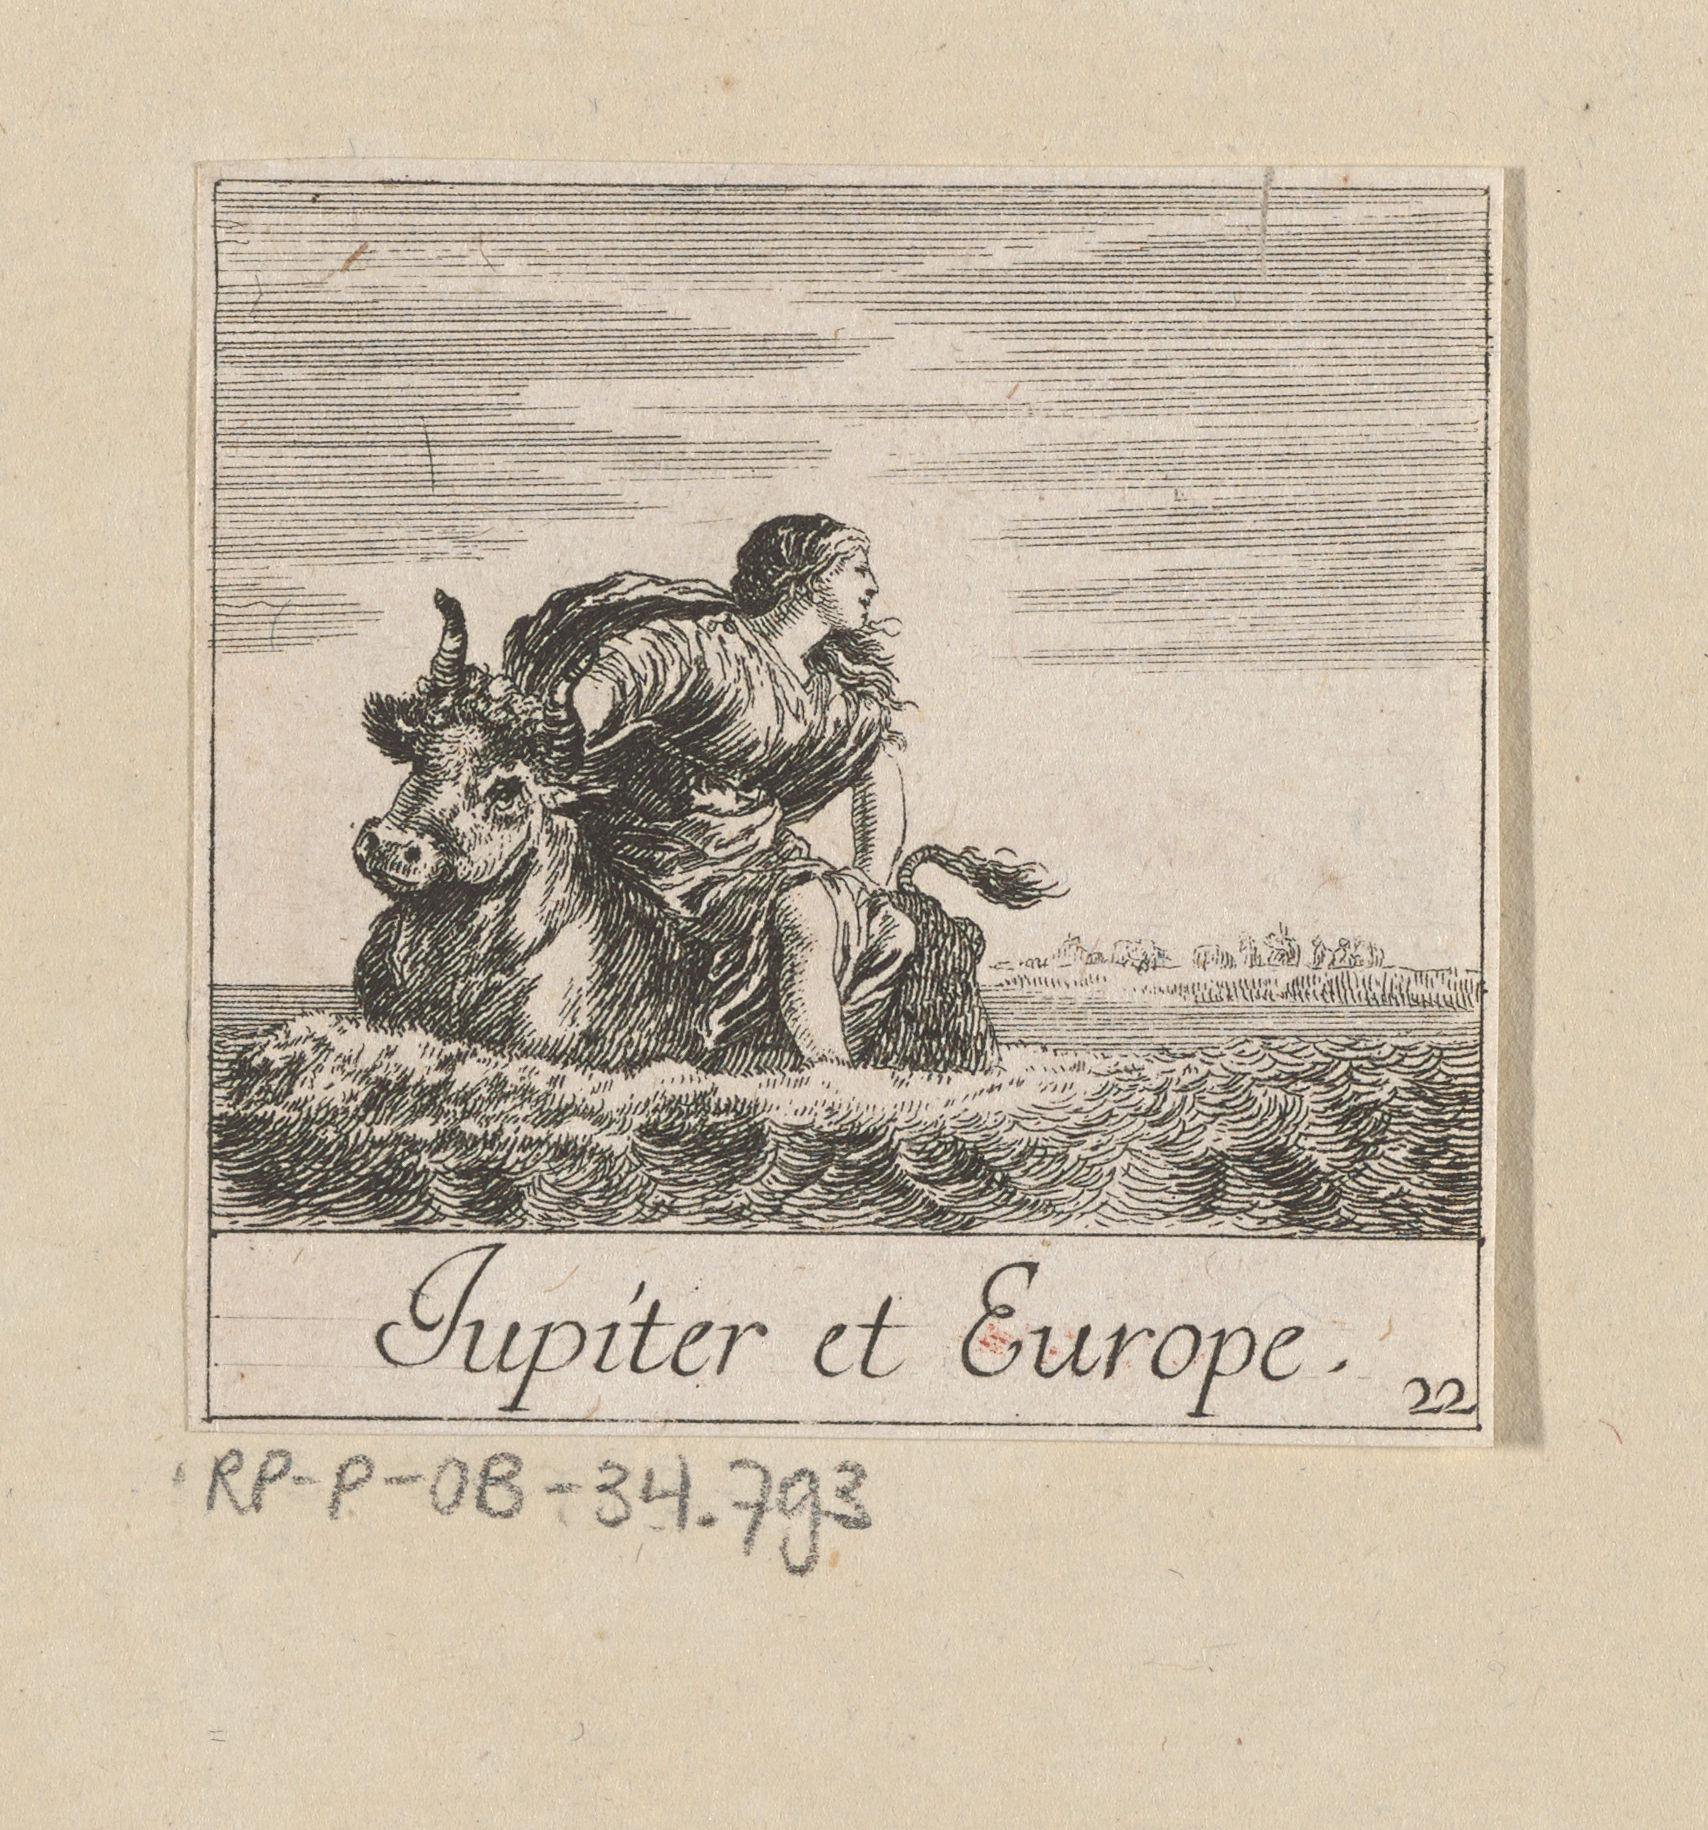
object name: print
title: Jupiter en Europa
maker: Anonymous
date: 1620-1664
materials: paper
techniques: etching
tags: jupiter, usually in the shape of a white bull, abducts europa and carries her across the water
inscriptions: collector's mark: Lugt 240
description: Prent uit een reeks van 54 genummerde speelkaarten met voorstellingen uit de Metamorfosen van Ovidius.